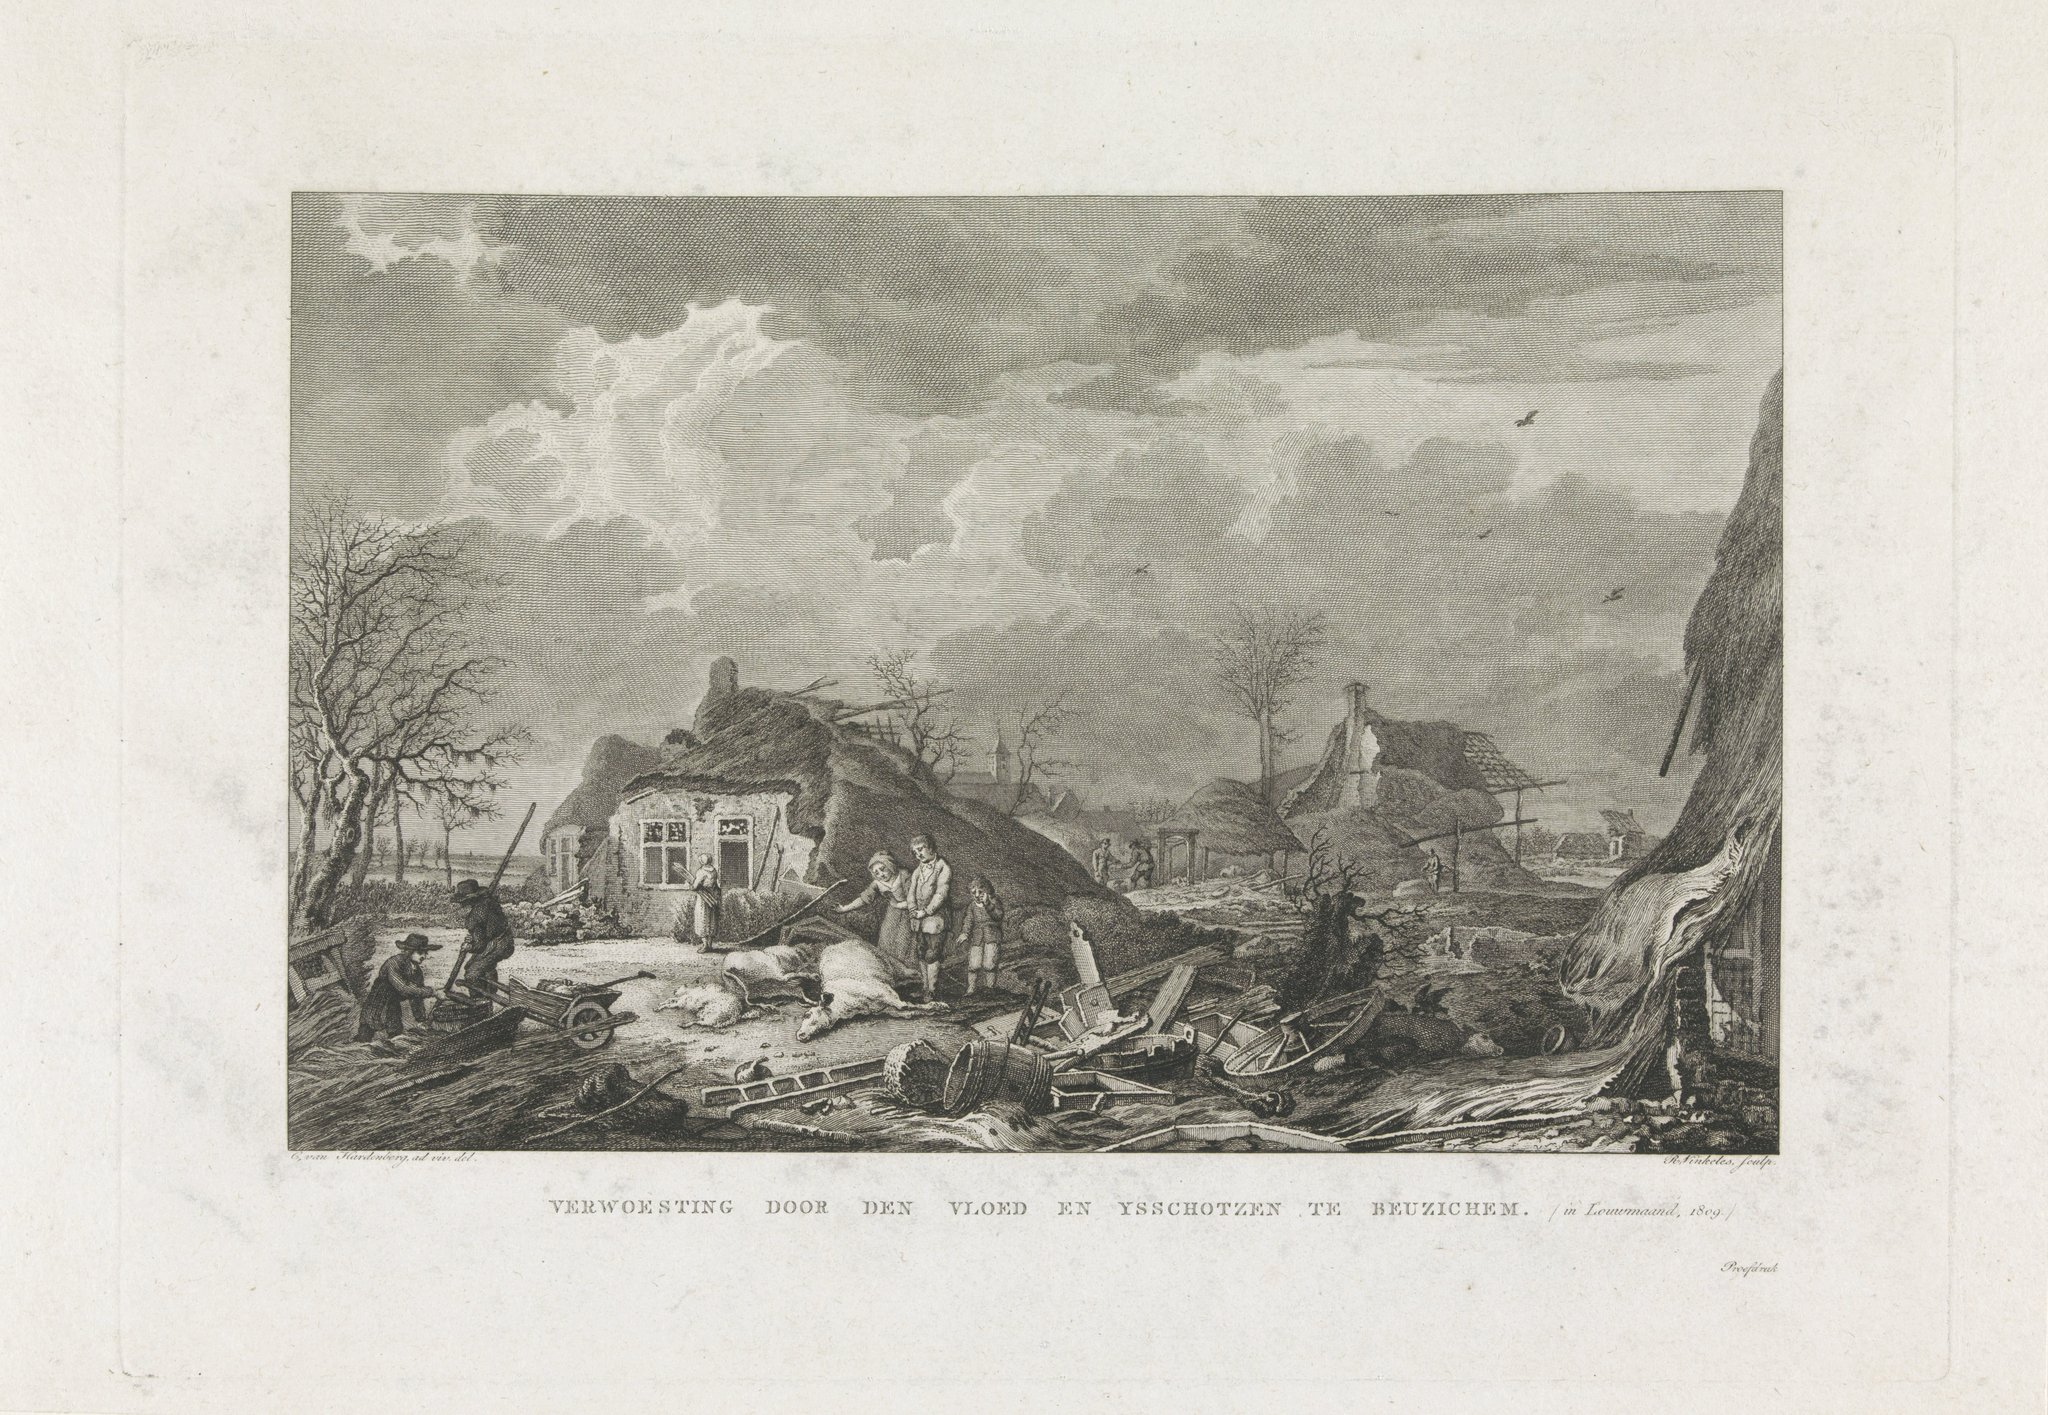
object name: print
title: Verwoestingen te Beusichem, 1809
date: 1809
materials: paper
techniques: engraving, etching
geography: netherlands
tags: dike-break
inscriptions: collector's mark: Lugt 2228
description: Gebruikt als illustratie in: Hendrik Ewijk. Geschiedkundig verslag der dijkbreuken en overstroomingen, langs de rivieren in het Koningrijk Holland, voorgevallen in louwmaand MDCCCIX. 3 dln. Amsterdam: Johannes Allart en Jacobus Ruys, 1809.